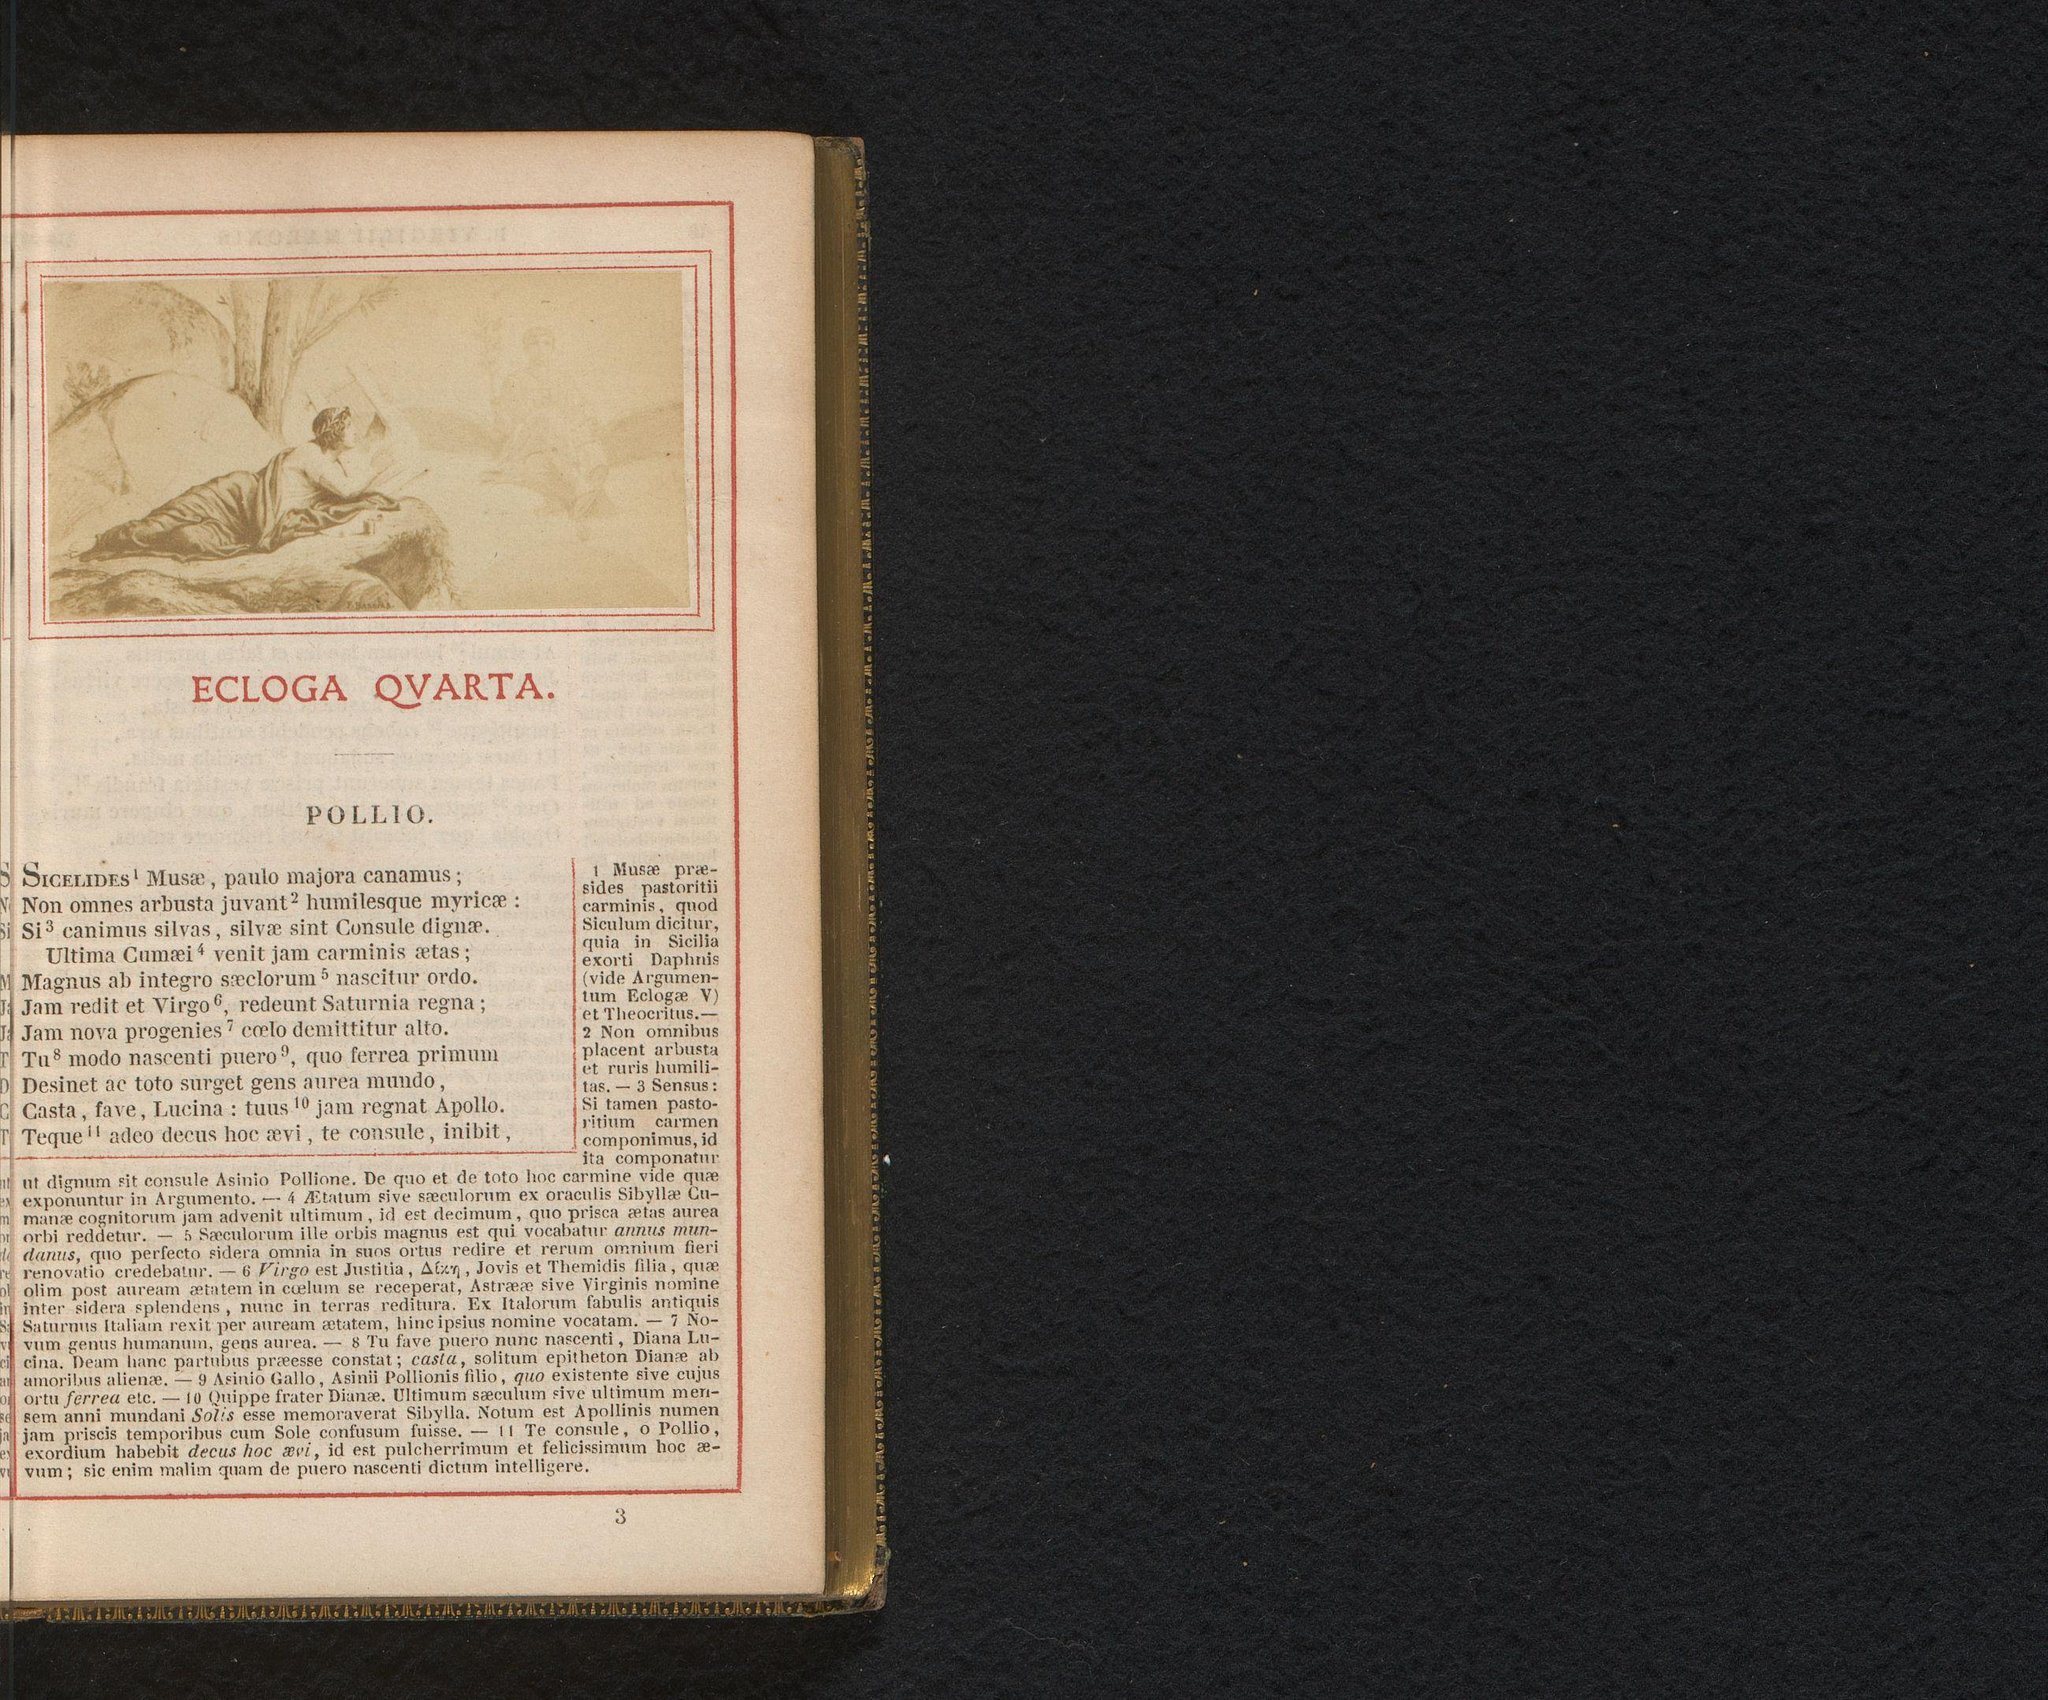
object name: page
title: Fotoreproductie van een schilderij, voorstellende (vermoedelijk) Vergilius met een lier en de schim van Gaius Asinius Pollio I, scène uit Virgilius' Bucolica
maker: Anonymous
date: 1853-1858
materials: paper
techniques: albumen print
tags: politician, lyre, cithara, psaltery, spirit, ghost, writer, poet, author